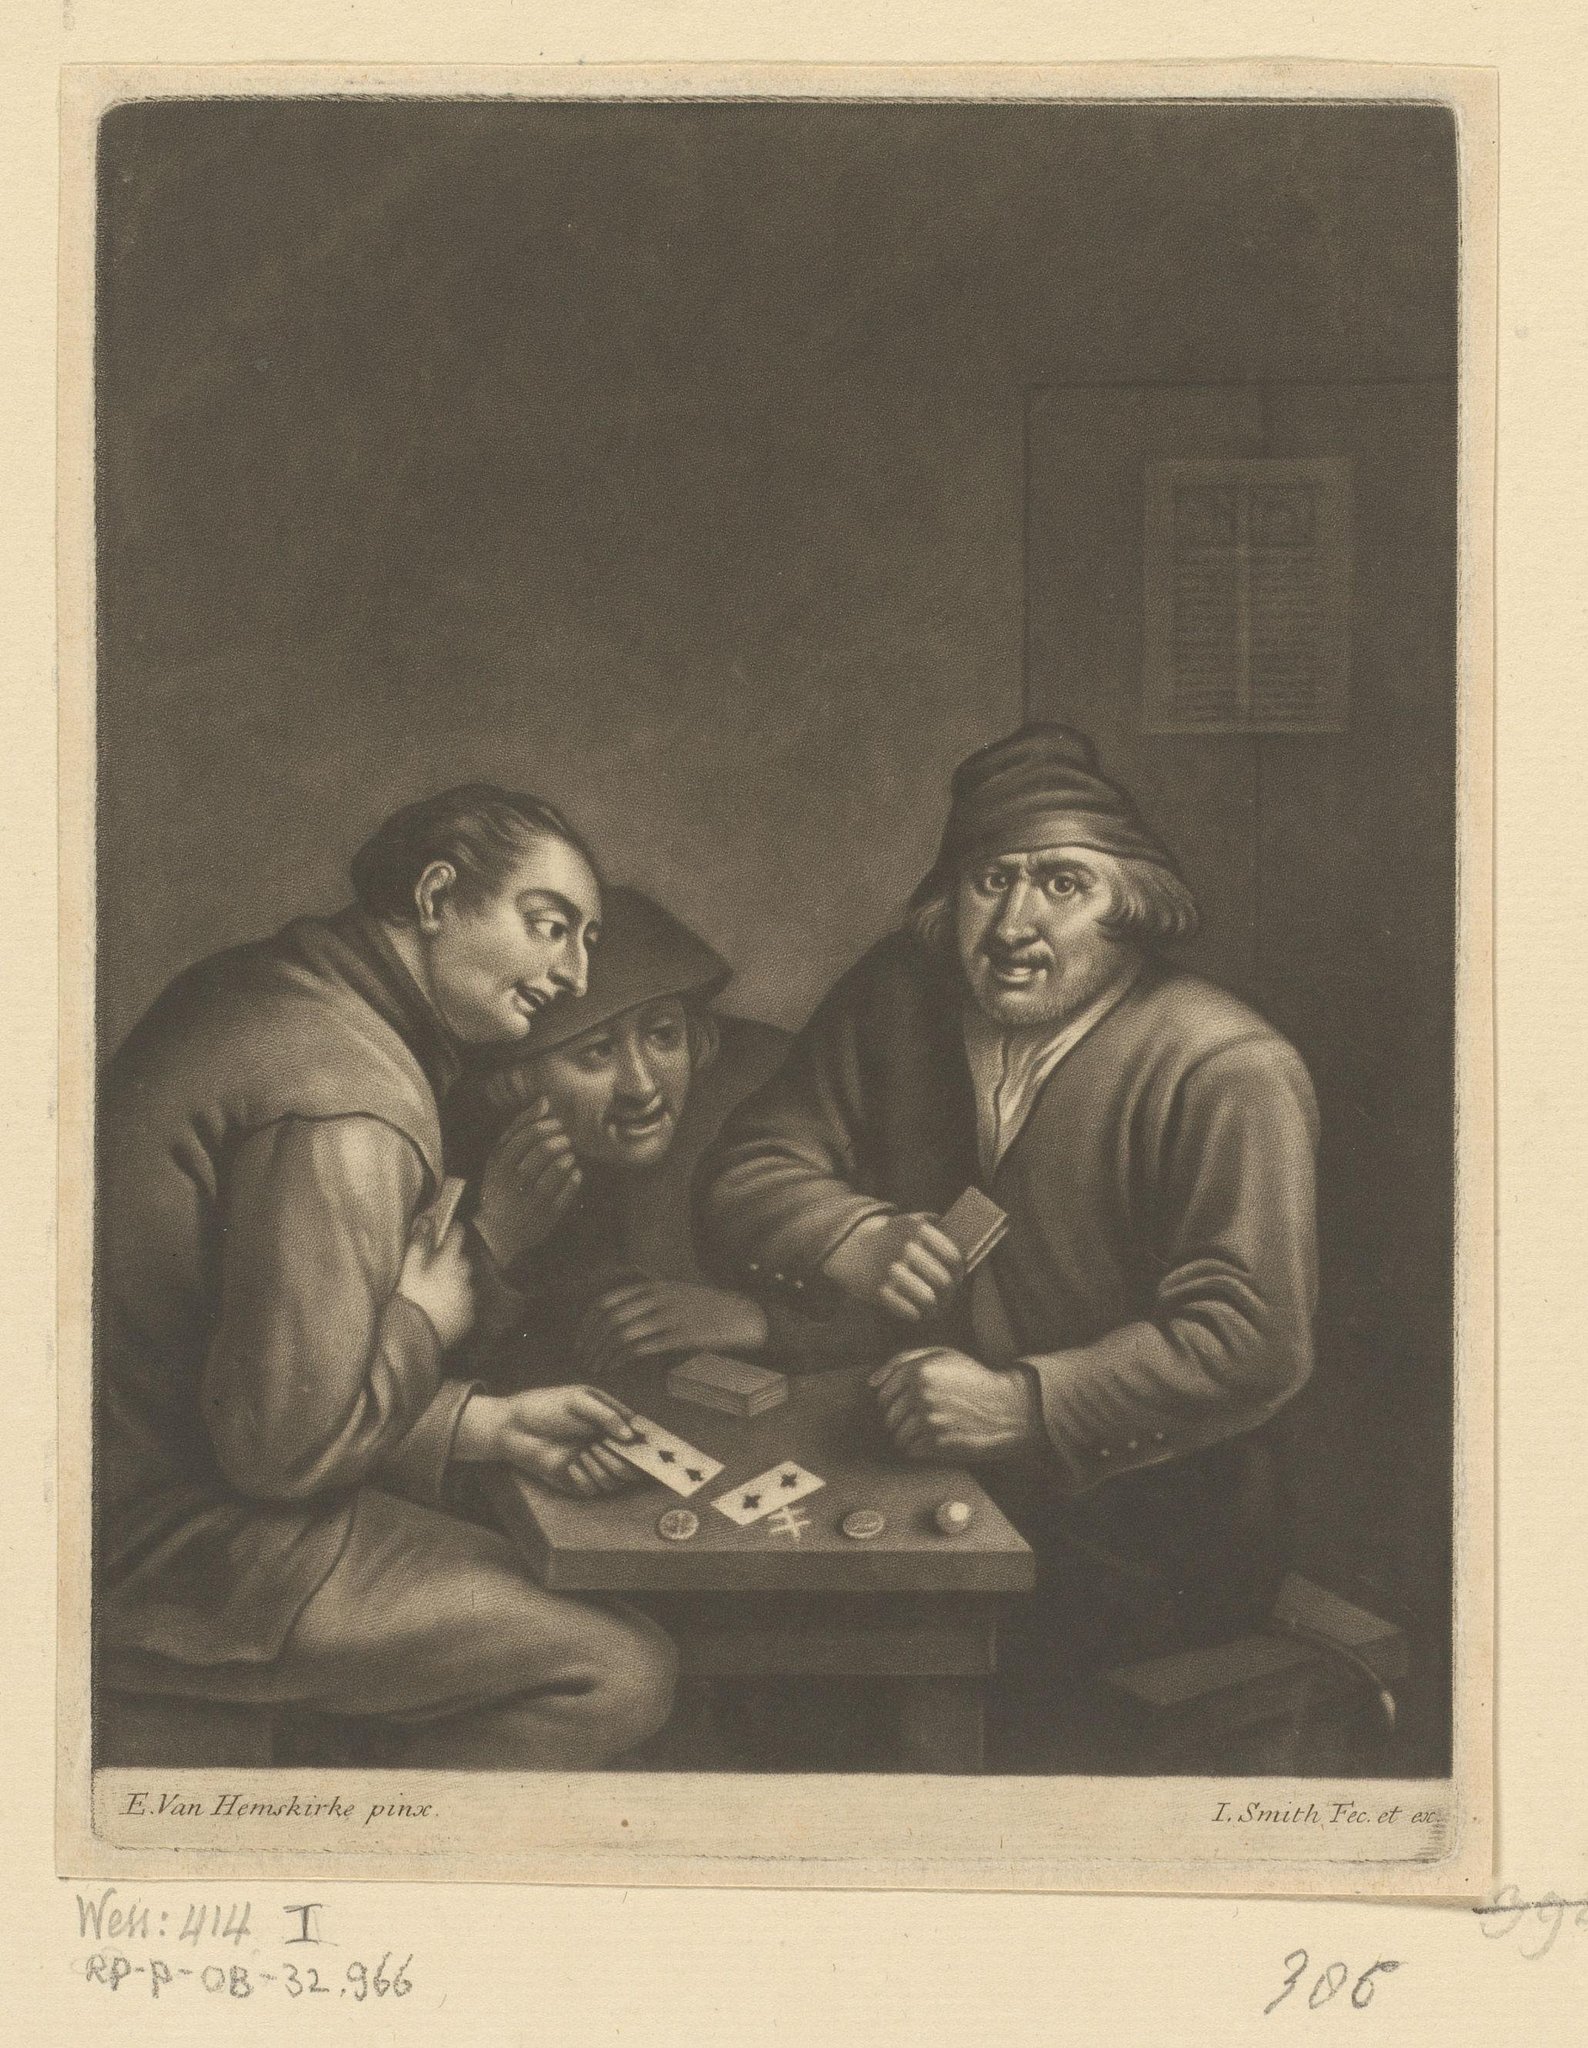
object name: print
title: Kaartspelers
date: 1662-1704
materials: paper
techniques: mezzotint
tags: adult man, card games (+ sportsman, player, etc.), hotel, hostelry, inn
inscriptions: collector's mark: Lugt 240